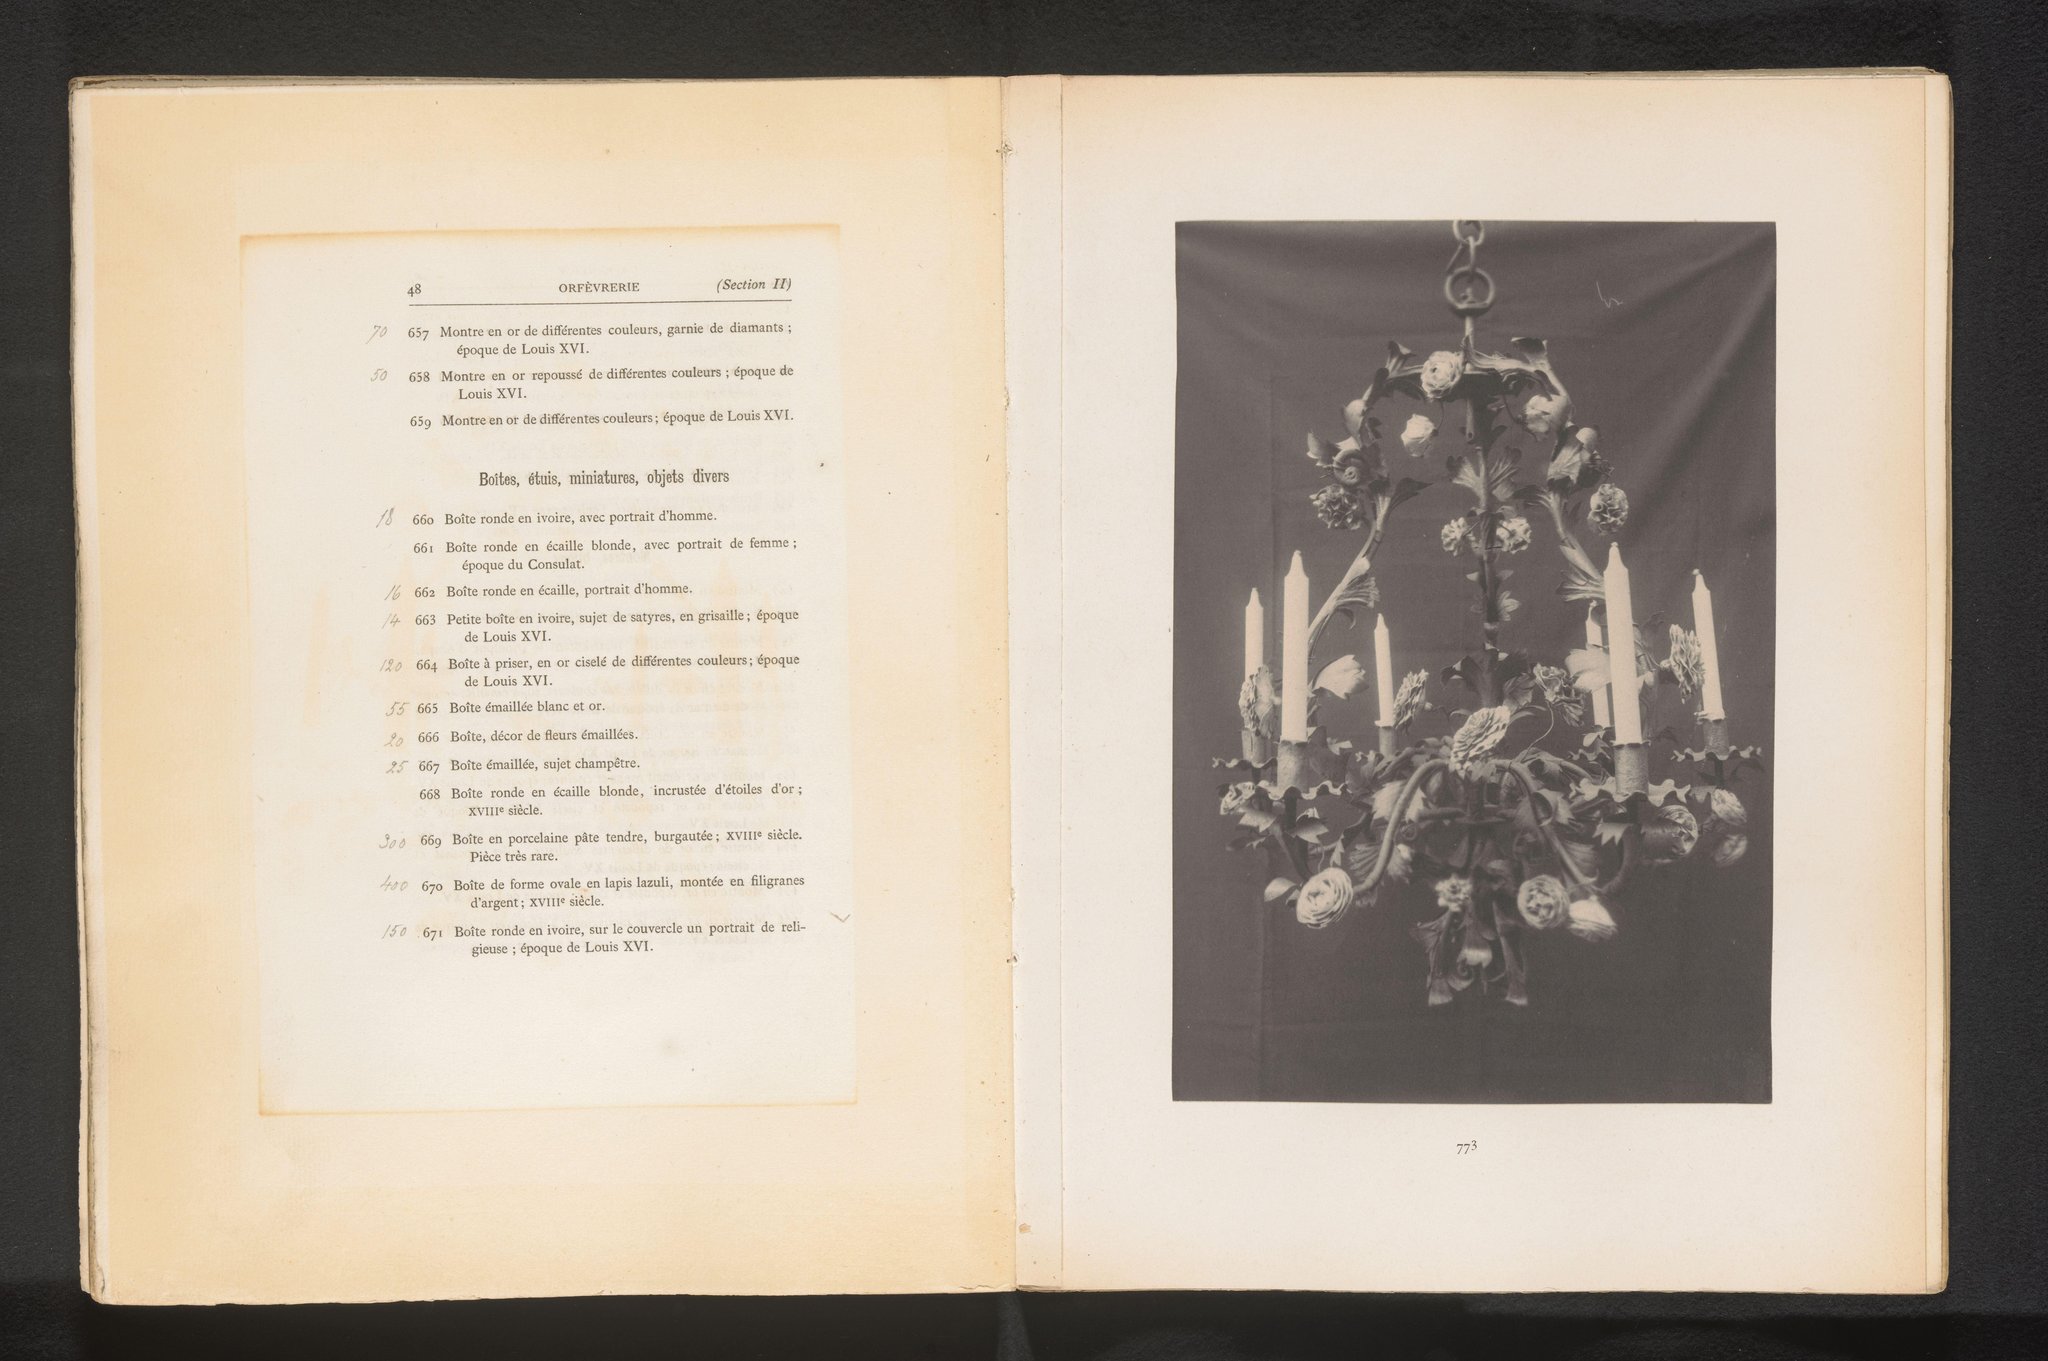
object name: photograph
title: Smeedijzeren kroonluchter uit de collectie van Antonin Terme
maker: Anonymous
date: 1880-1885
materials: photographic support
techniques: platinum process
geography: liège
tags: art collection, art gallery, chandelier, candelabrum